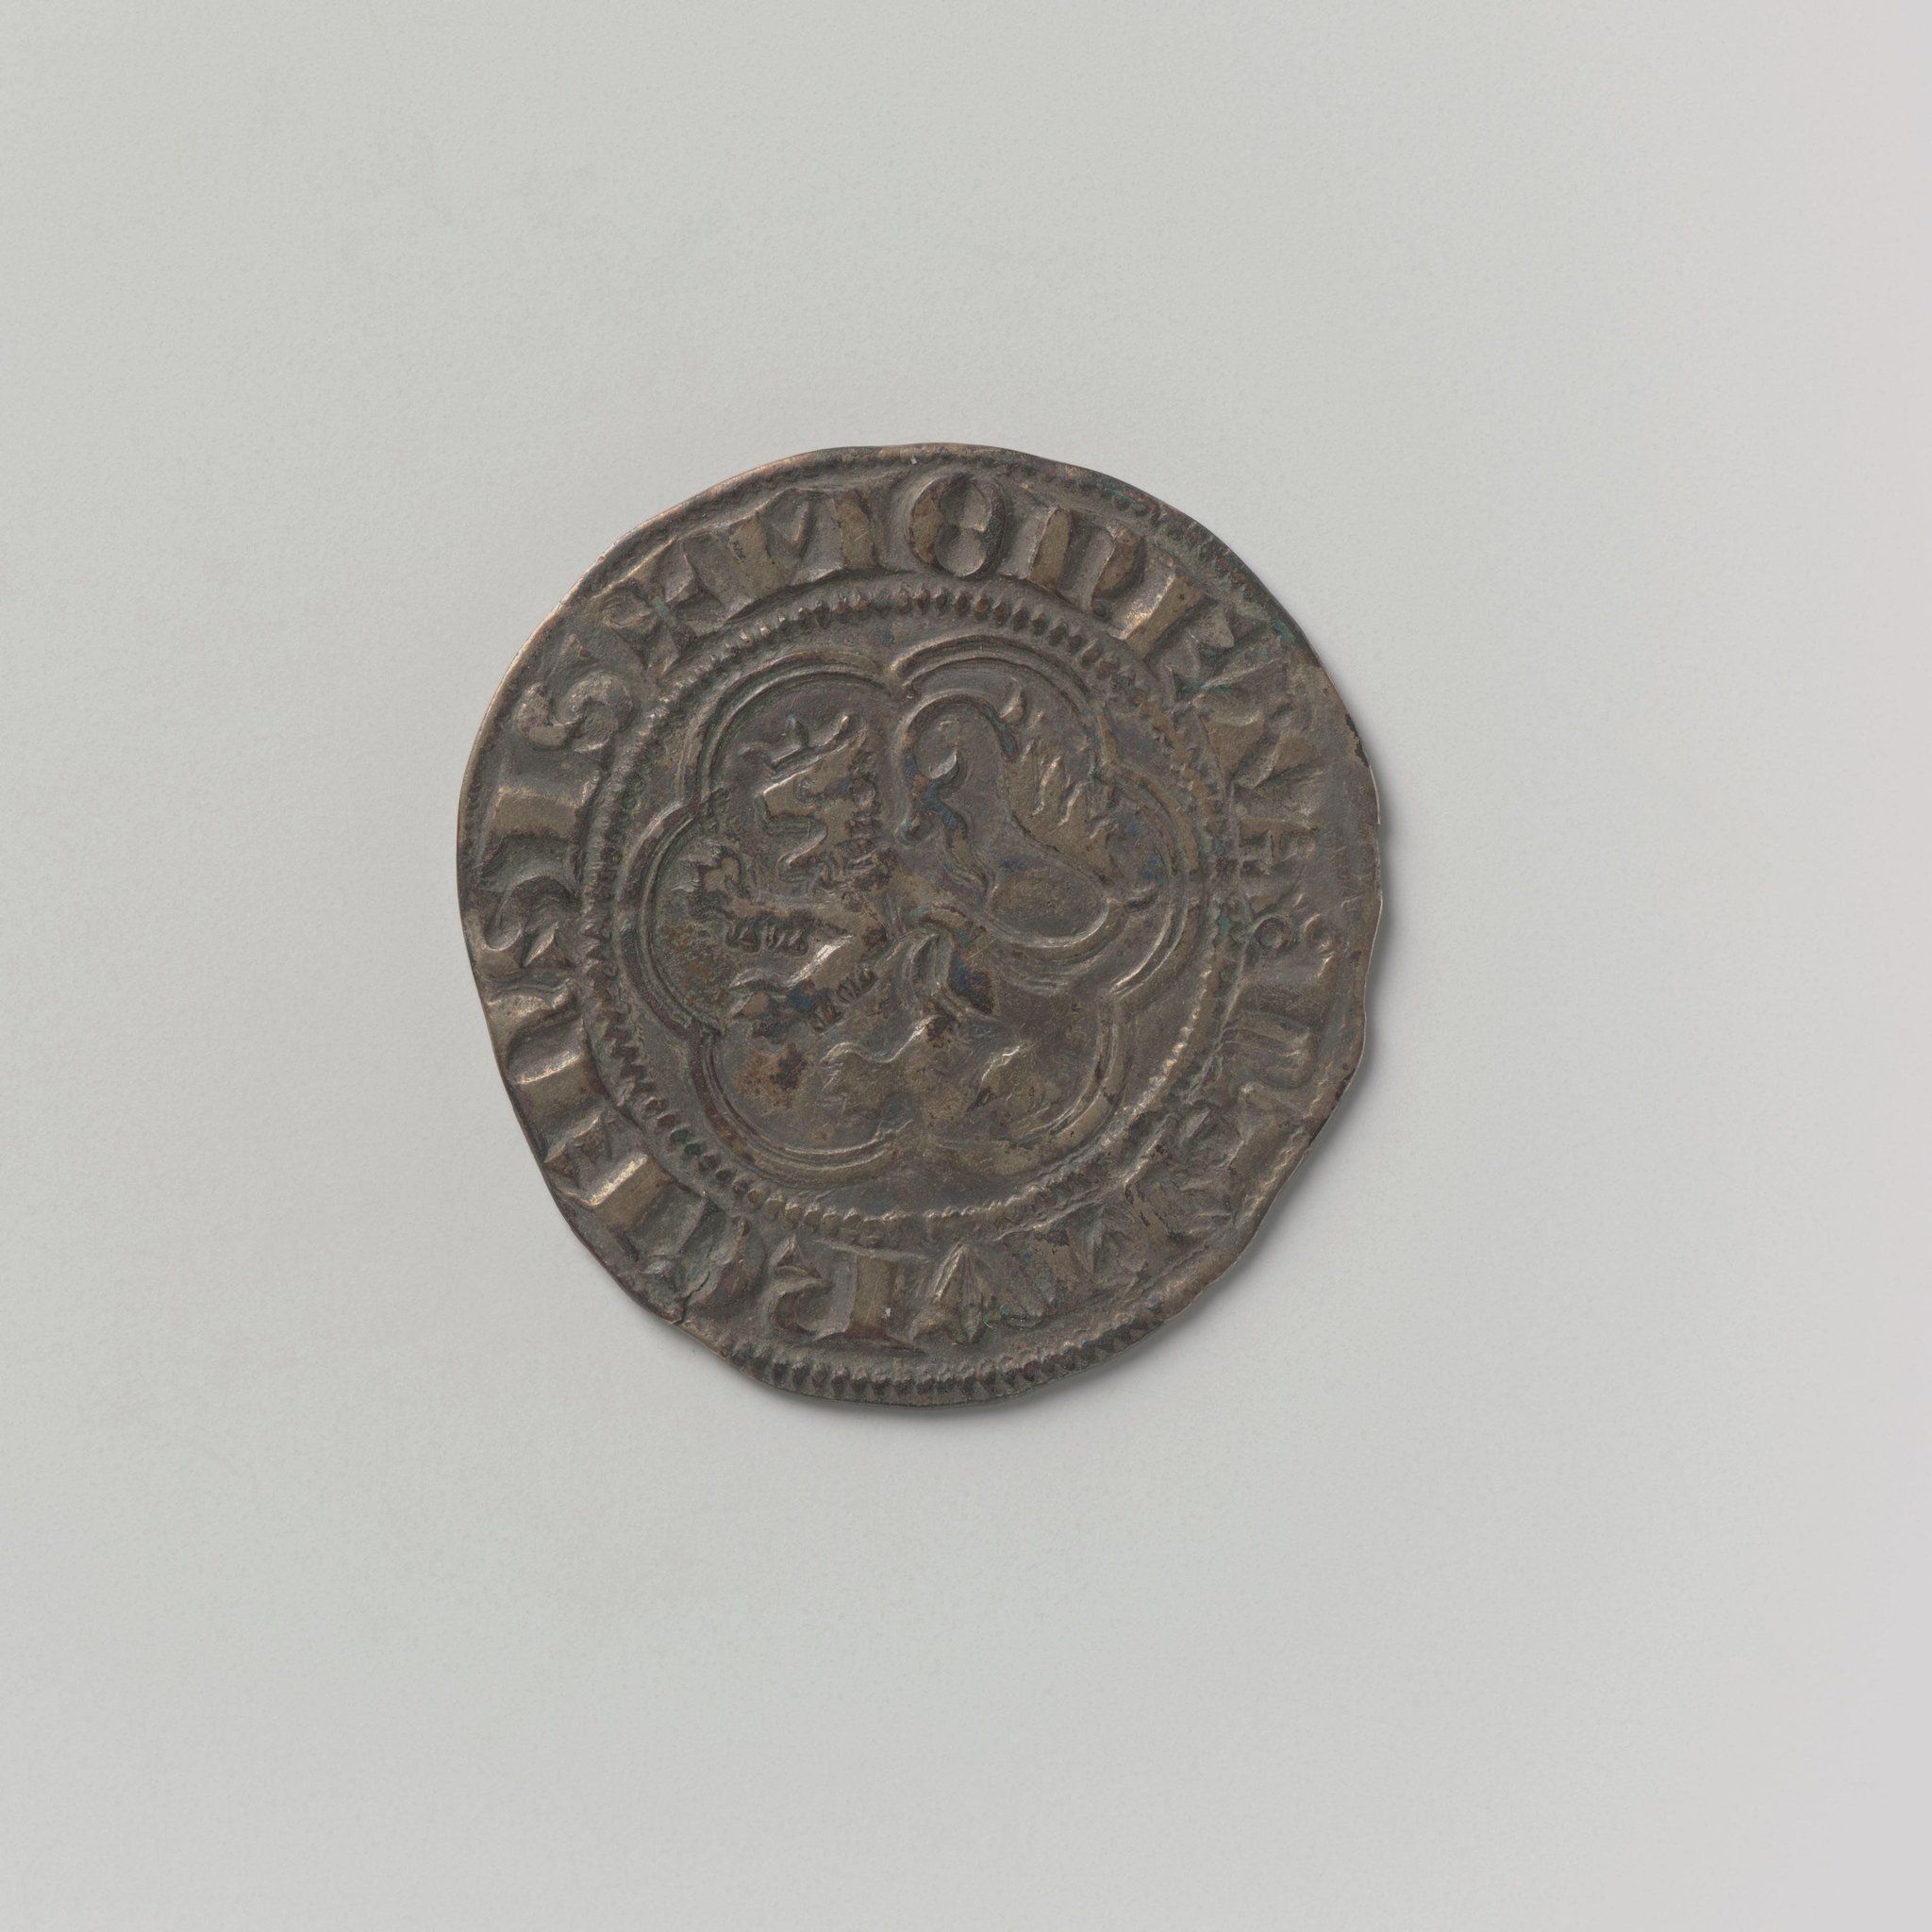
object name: coin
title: Namen, Guido II, 2/3 groot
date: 1335-1336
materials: silver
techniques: striking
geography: namur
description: Zilveren munt. Voorzijde: in een zespas klimmende leeuw naar links. Keerzijde: lang gevoet kruis. In hoeken afwisselend adelaar en leeuw.